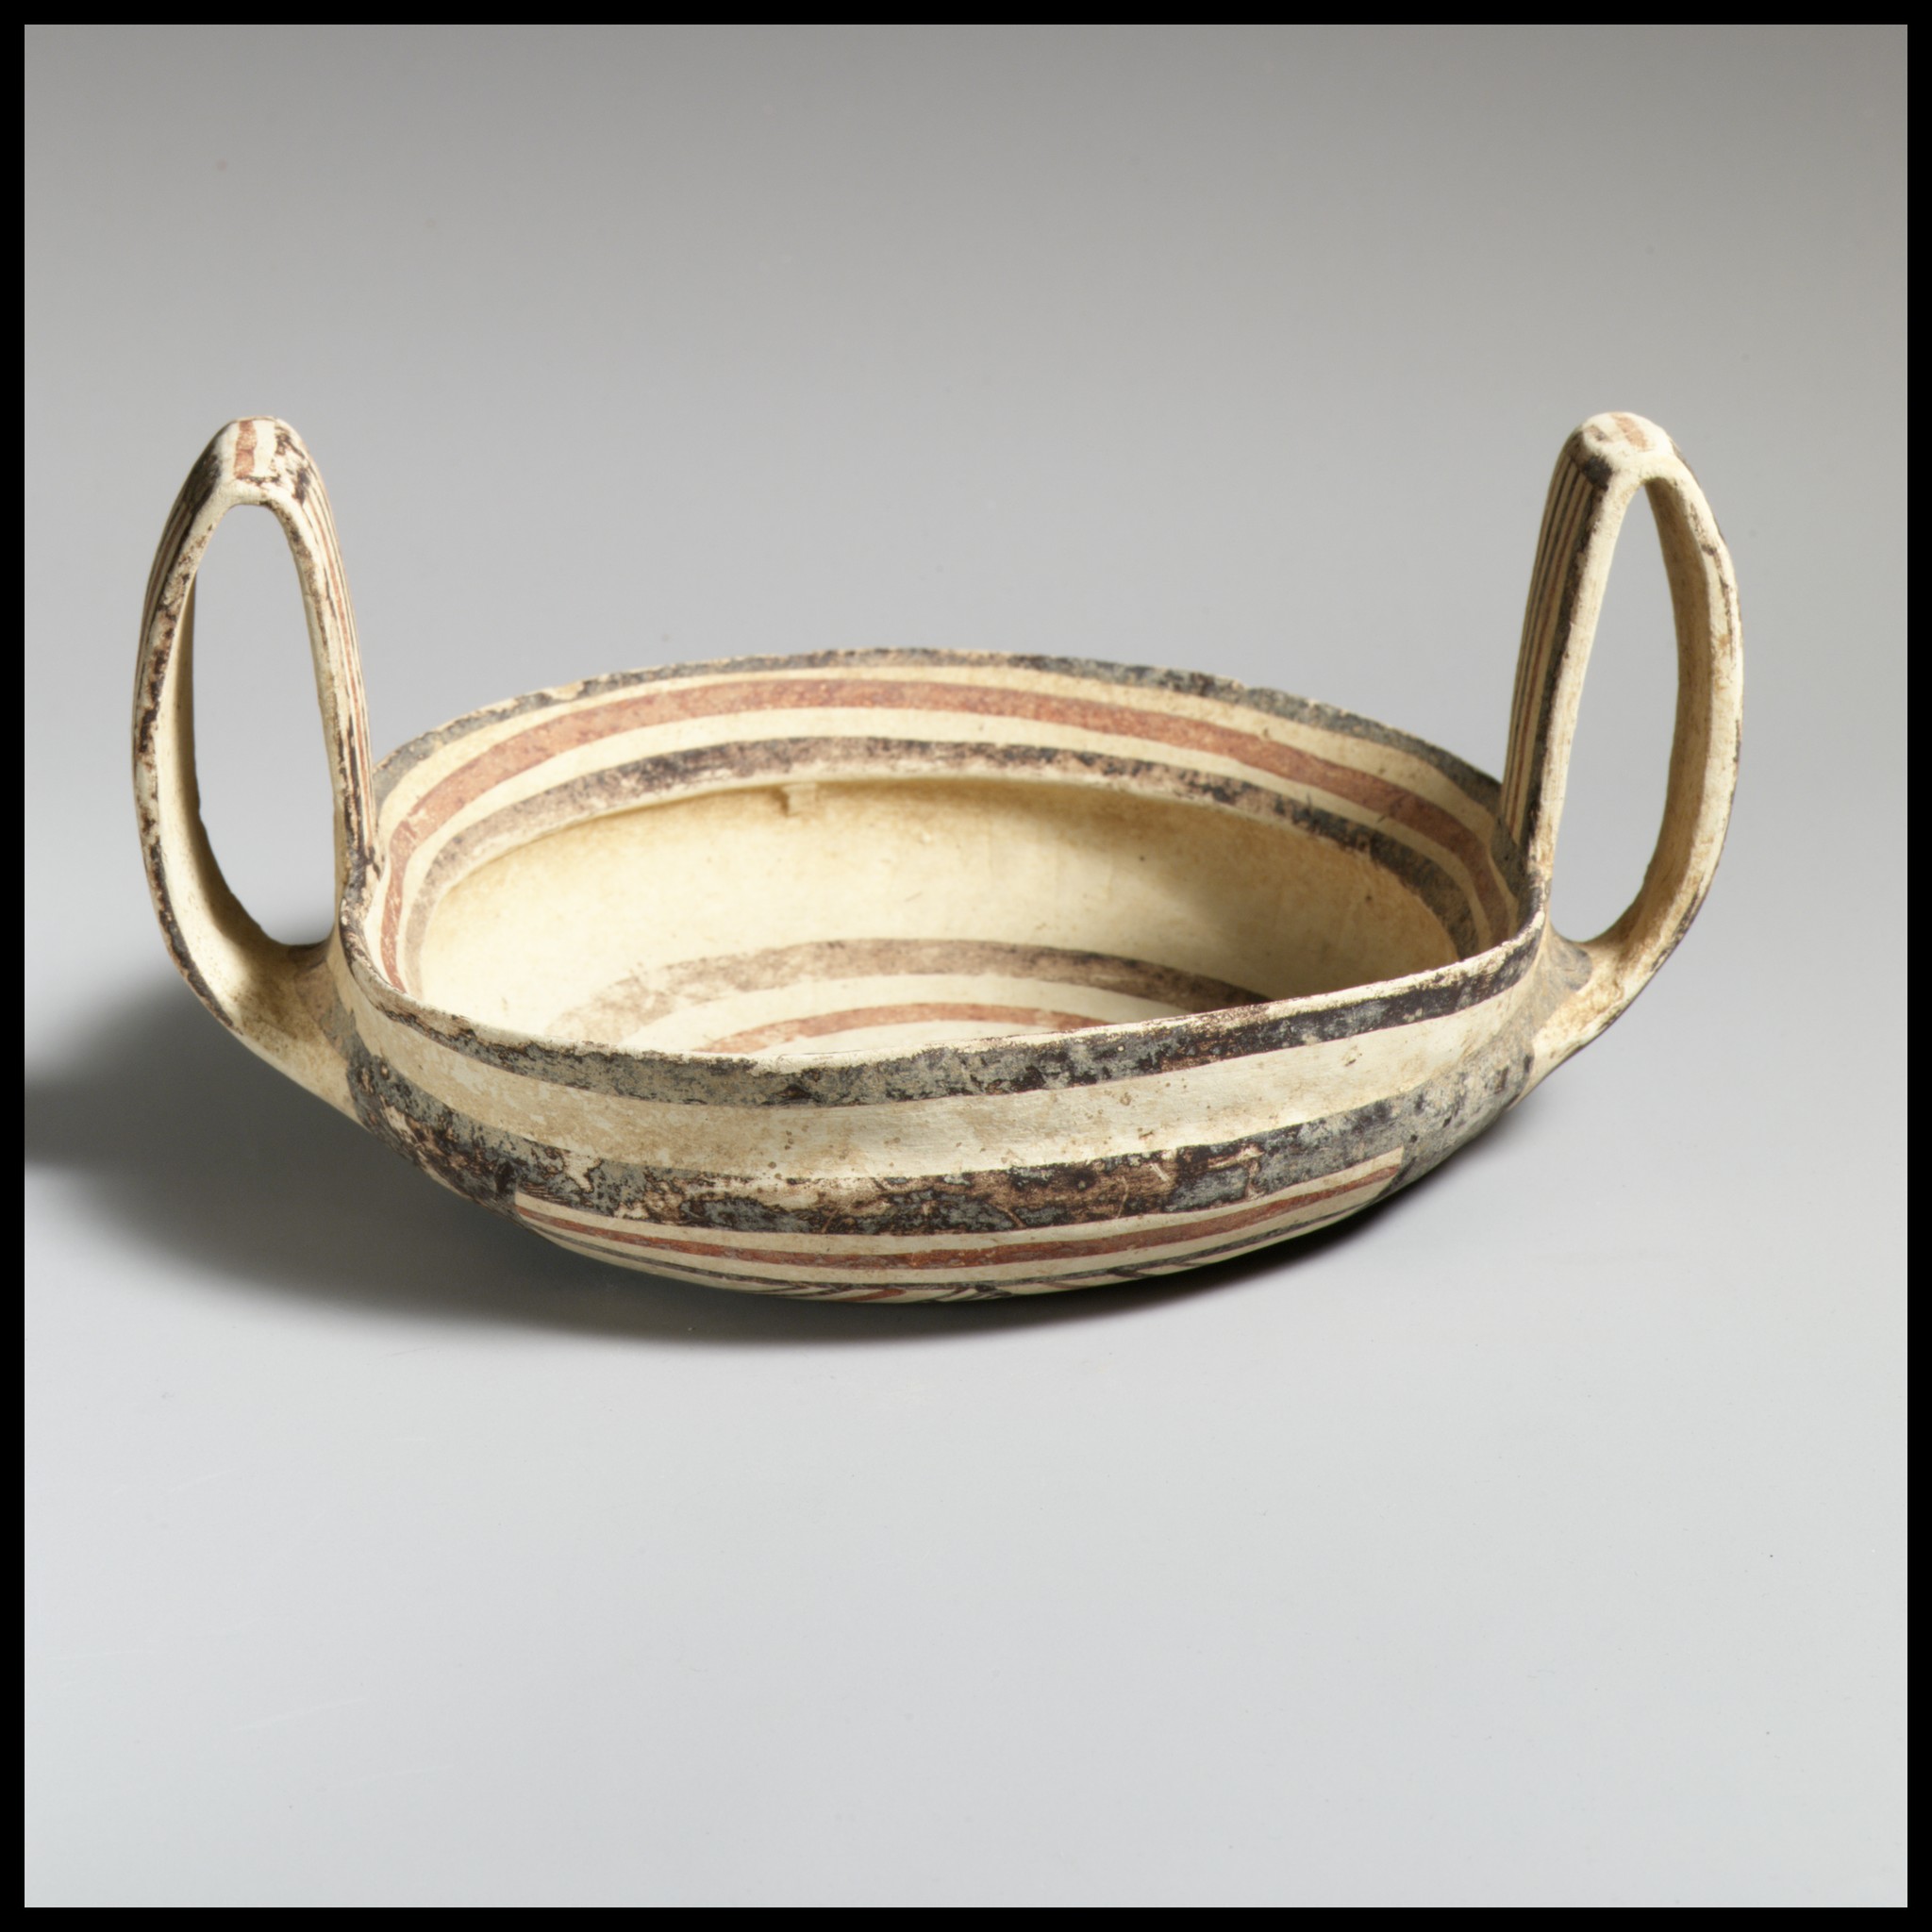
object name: bowl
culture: italic, daunian or south italian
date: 550-450 BCE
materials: terracotta